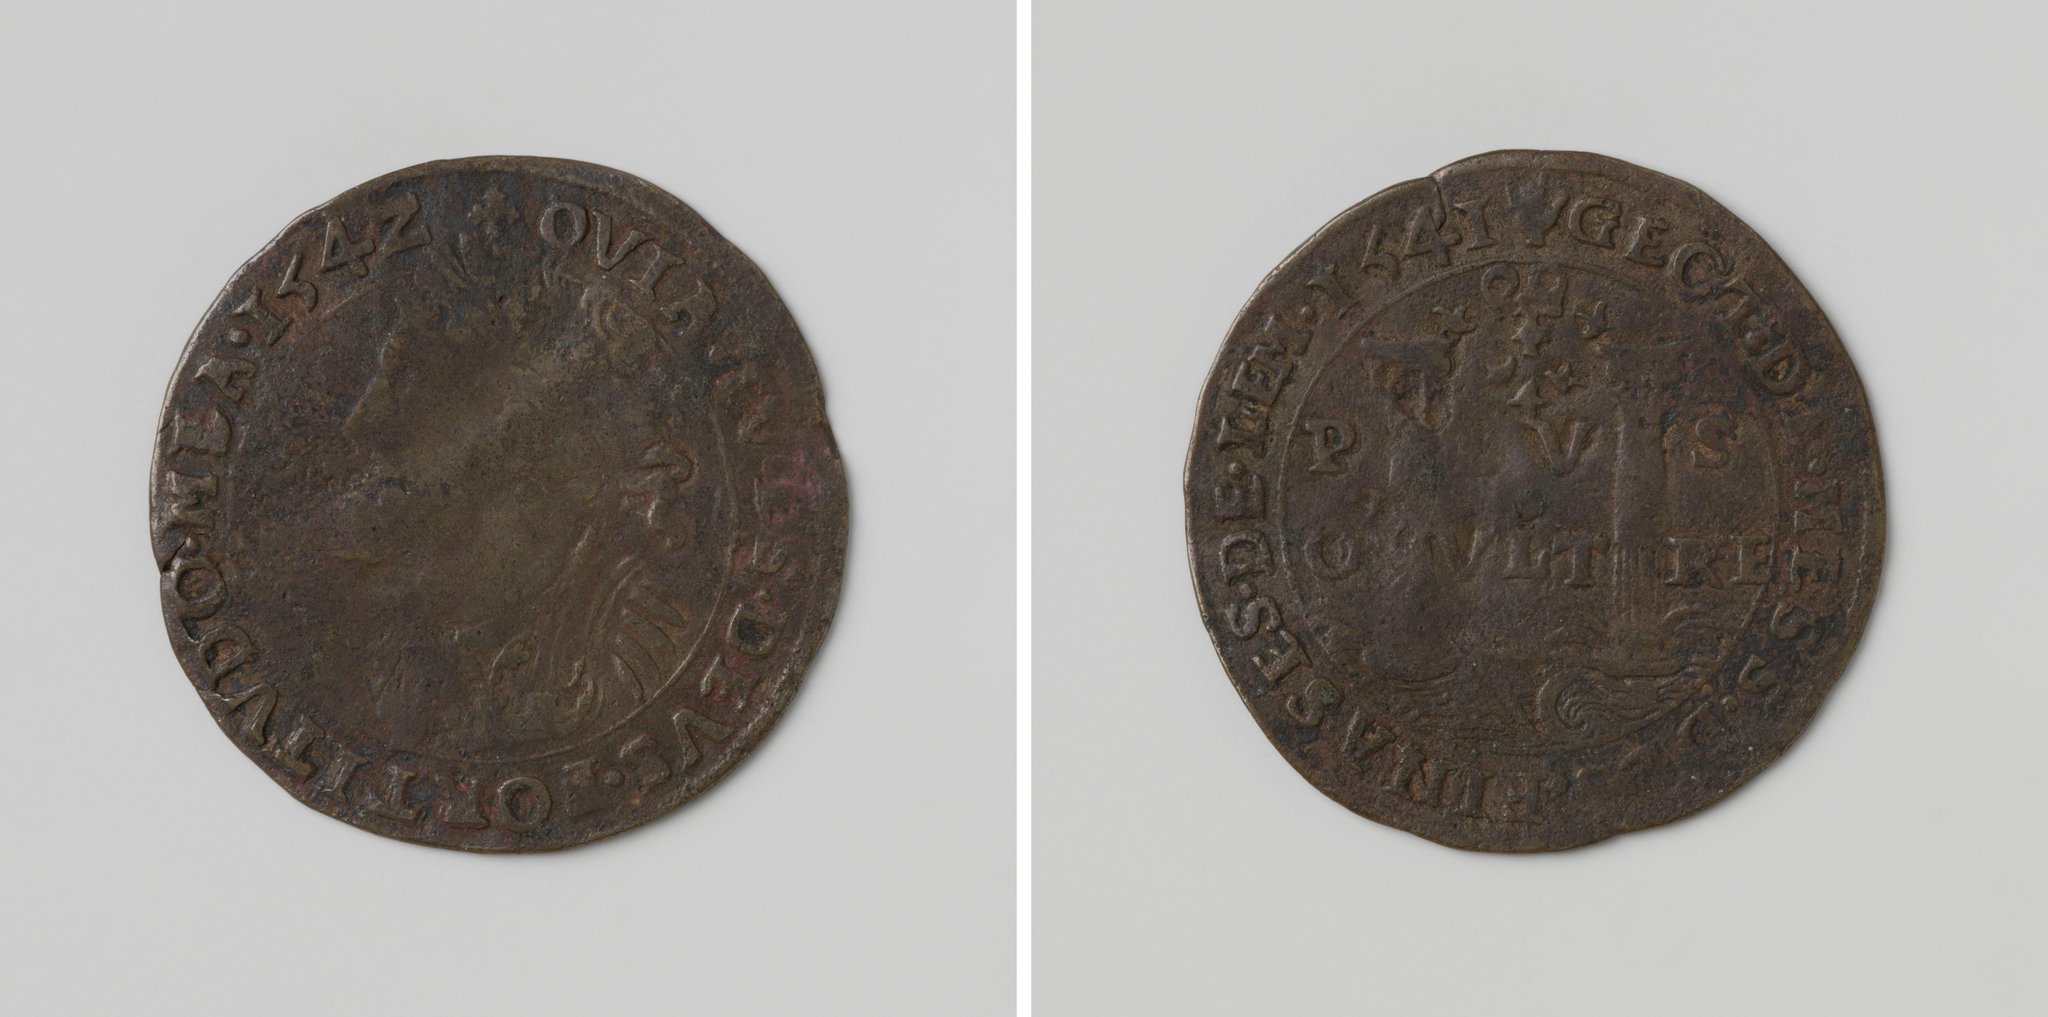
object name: jeton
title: Karel V, Duits keizer, rekenpenning van de raad van Financiën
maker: Anonymous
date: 1541-1542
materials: copper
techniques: striking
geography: antwerp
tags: ghent, charles v (holy roman emperor and king of spain)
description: Koperen penning. Voorzijde: borststuk man met lauwerkrans binnen omschrift. Keerzijde: opschrift onder vuurslag, waar vonken uit schieten tussen zuilen van Herkules binnen omschrift